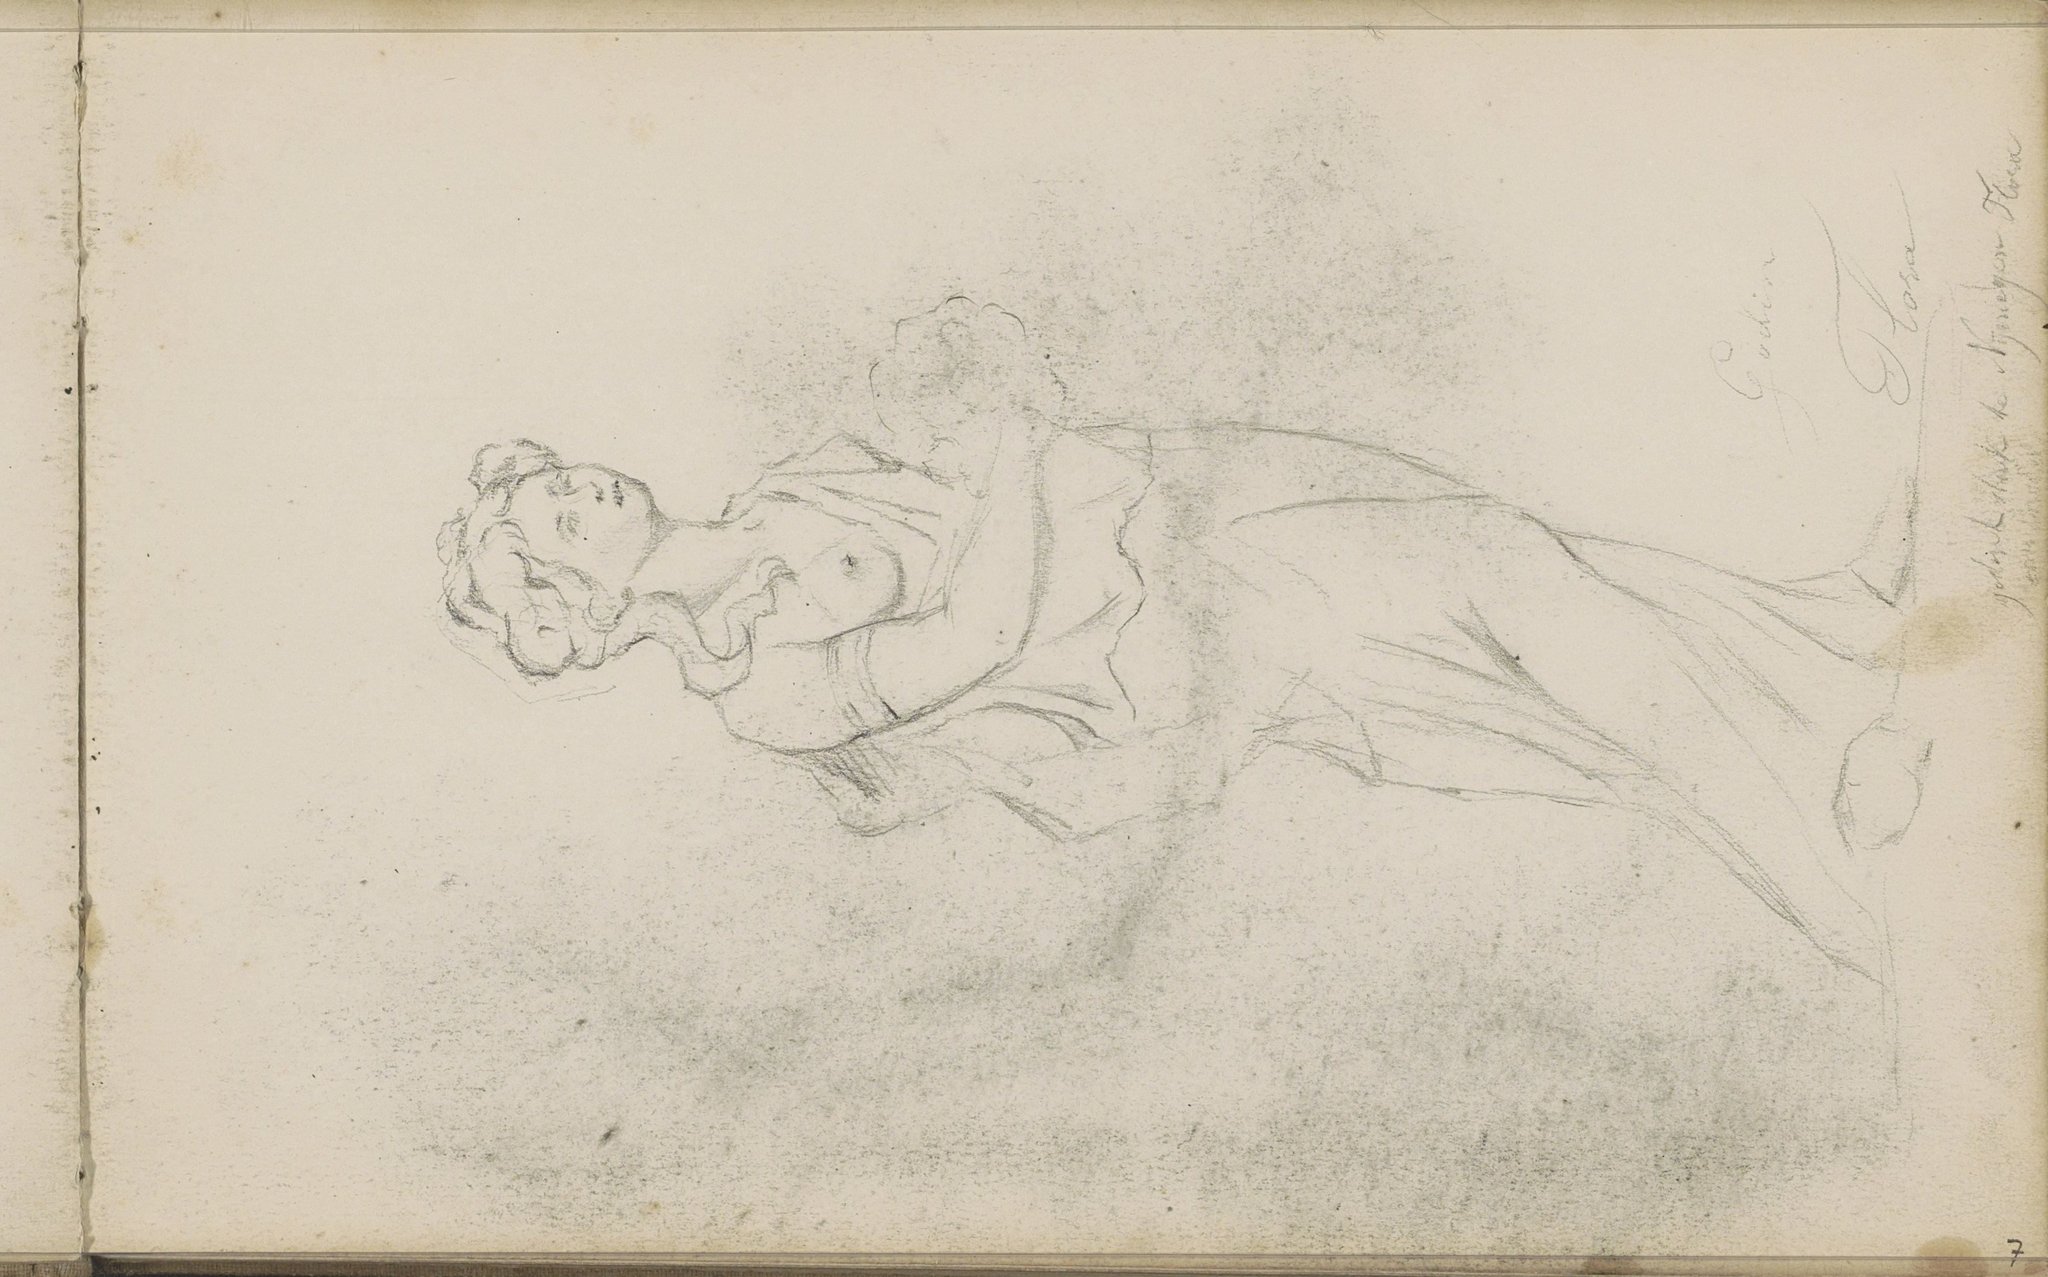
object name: sketchbook leaf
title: Standbeeld van de godin Flora te Nijmegen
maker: willem cornelis rip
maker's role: draughtsman, painter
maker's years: 1856-1922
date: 1874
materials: paper, pencil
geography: nijmegen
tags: monument, statue, (story of) flora, nijmegen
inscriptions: annotation: ‘Godin/ Flora/ godi[...] te Nijmegen Flora’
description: De godin draagt een uitbottende tak. Blad 7 recto uit een schetsboek met 47 bladen.